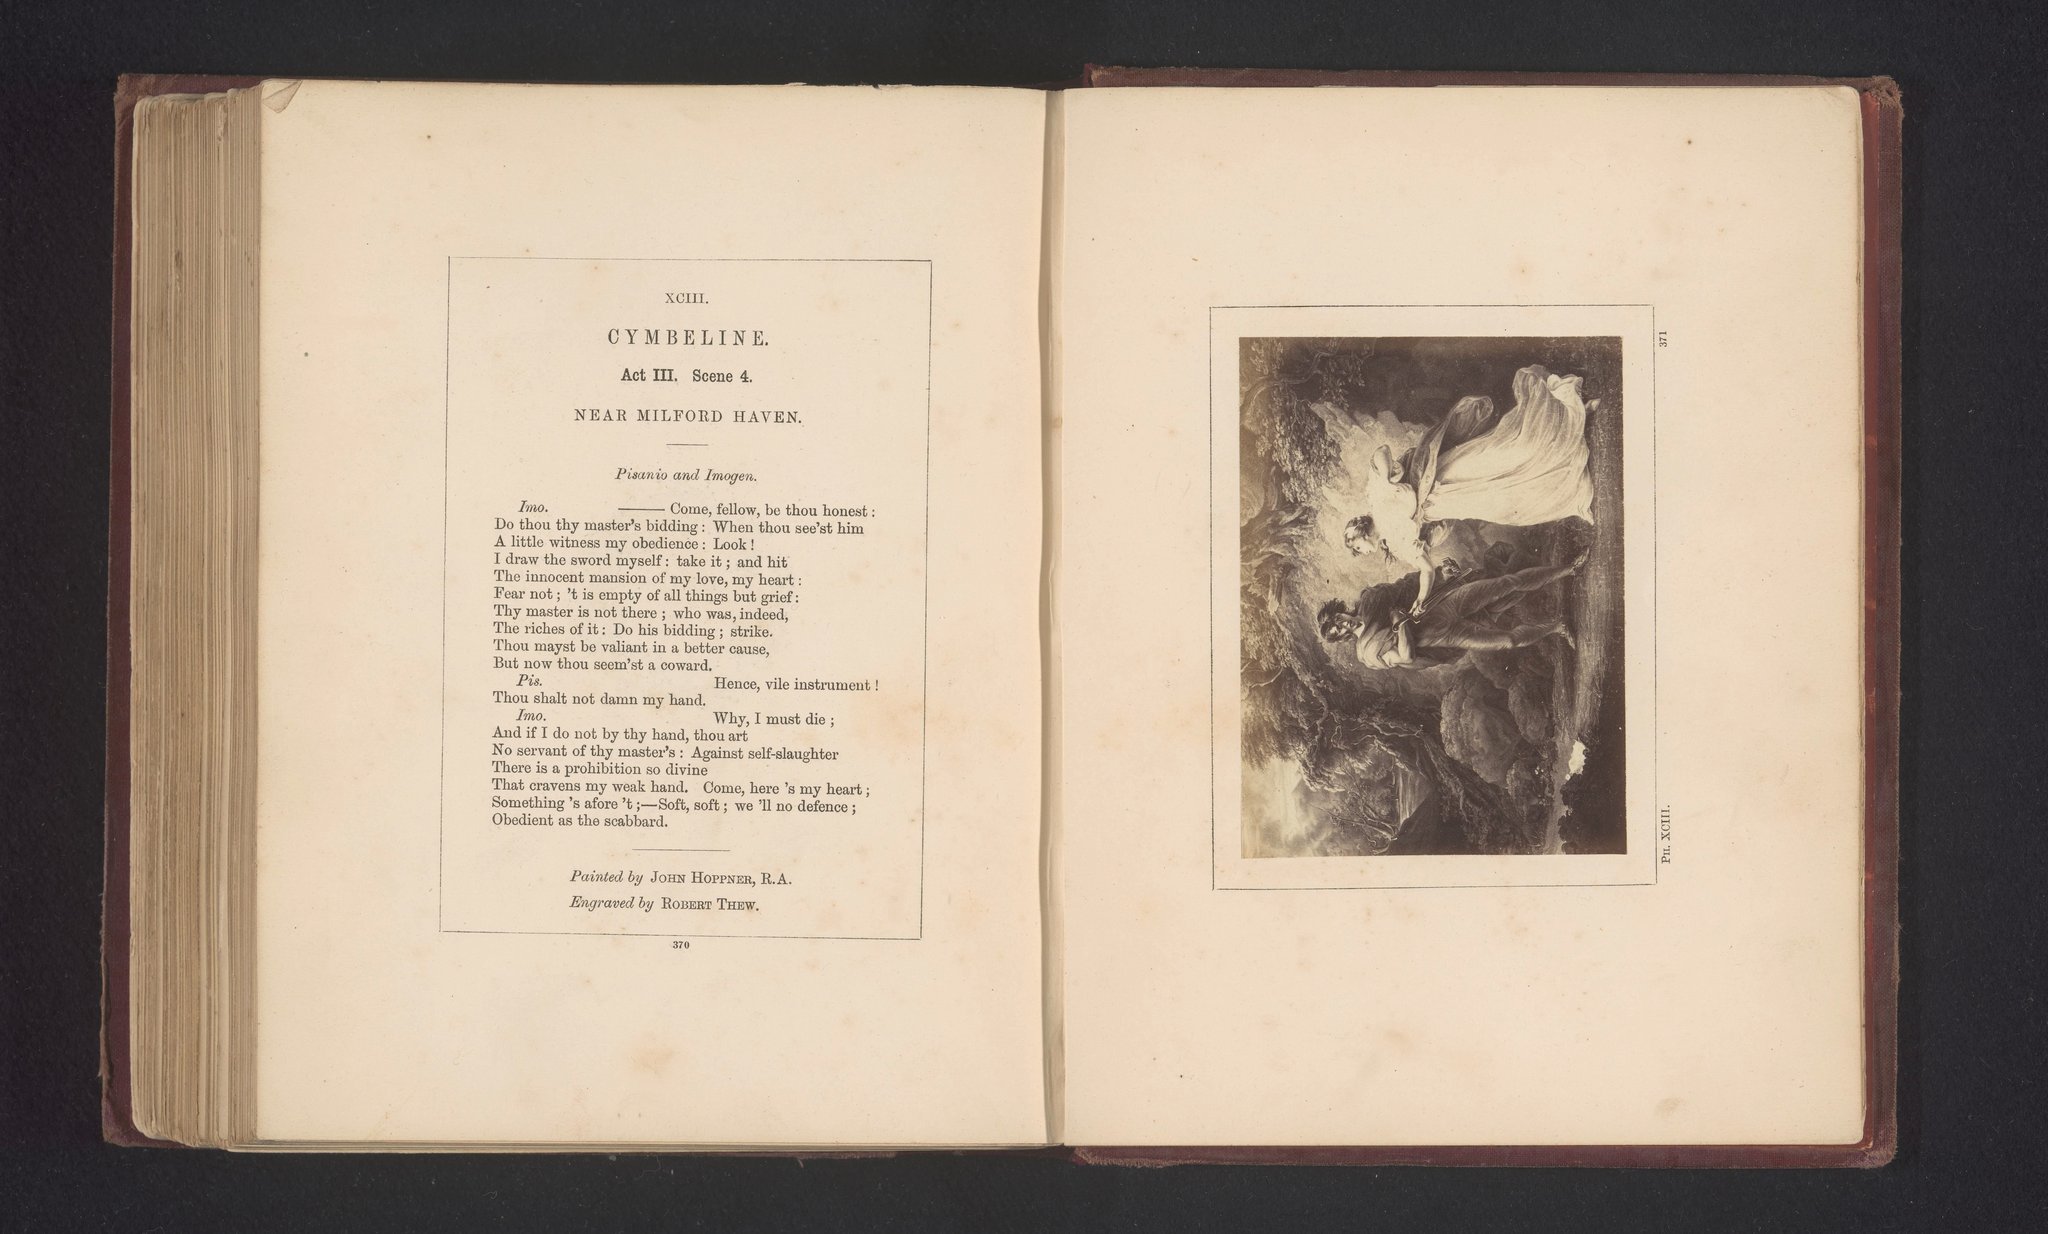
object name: page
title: Fotoreproductie van een prent naar een schilderij door John Hoppner, voorstellend een scene uit Cymbeline door William Shakespeare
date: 1854-1867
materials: photographic support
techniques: albumen print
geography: london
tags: (scenes from) specific works of literature: shakespeare, cymbeline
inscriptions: number: ‘Ph. XCIII. 371’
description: Te zien is akte III, scene 4 met Imogen en Pisanio bij Milford Haven.